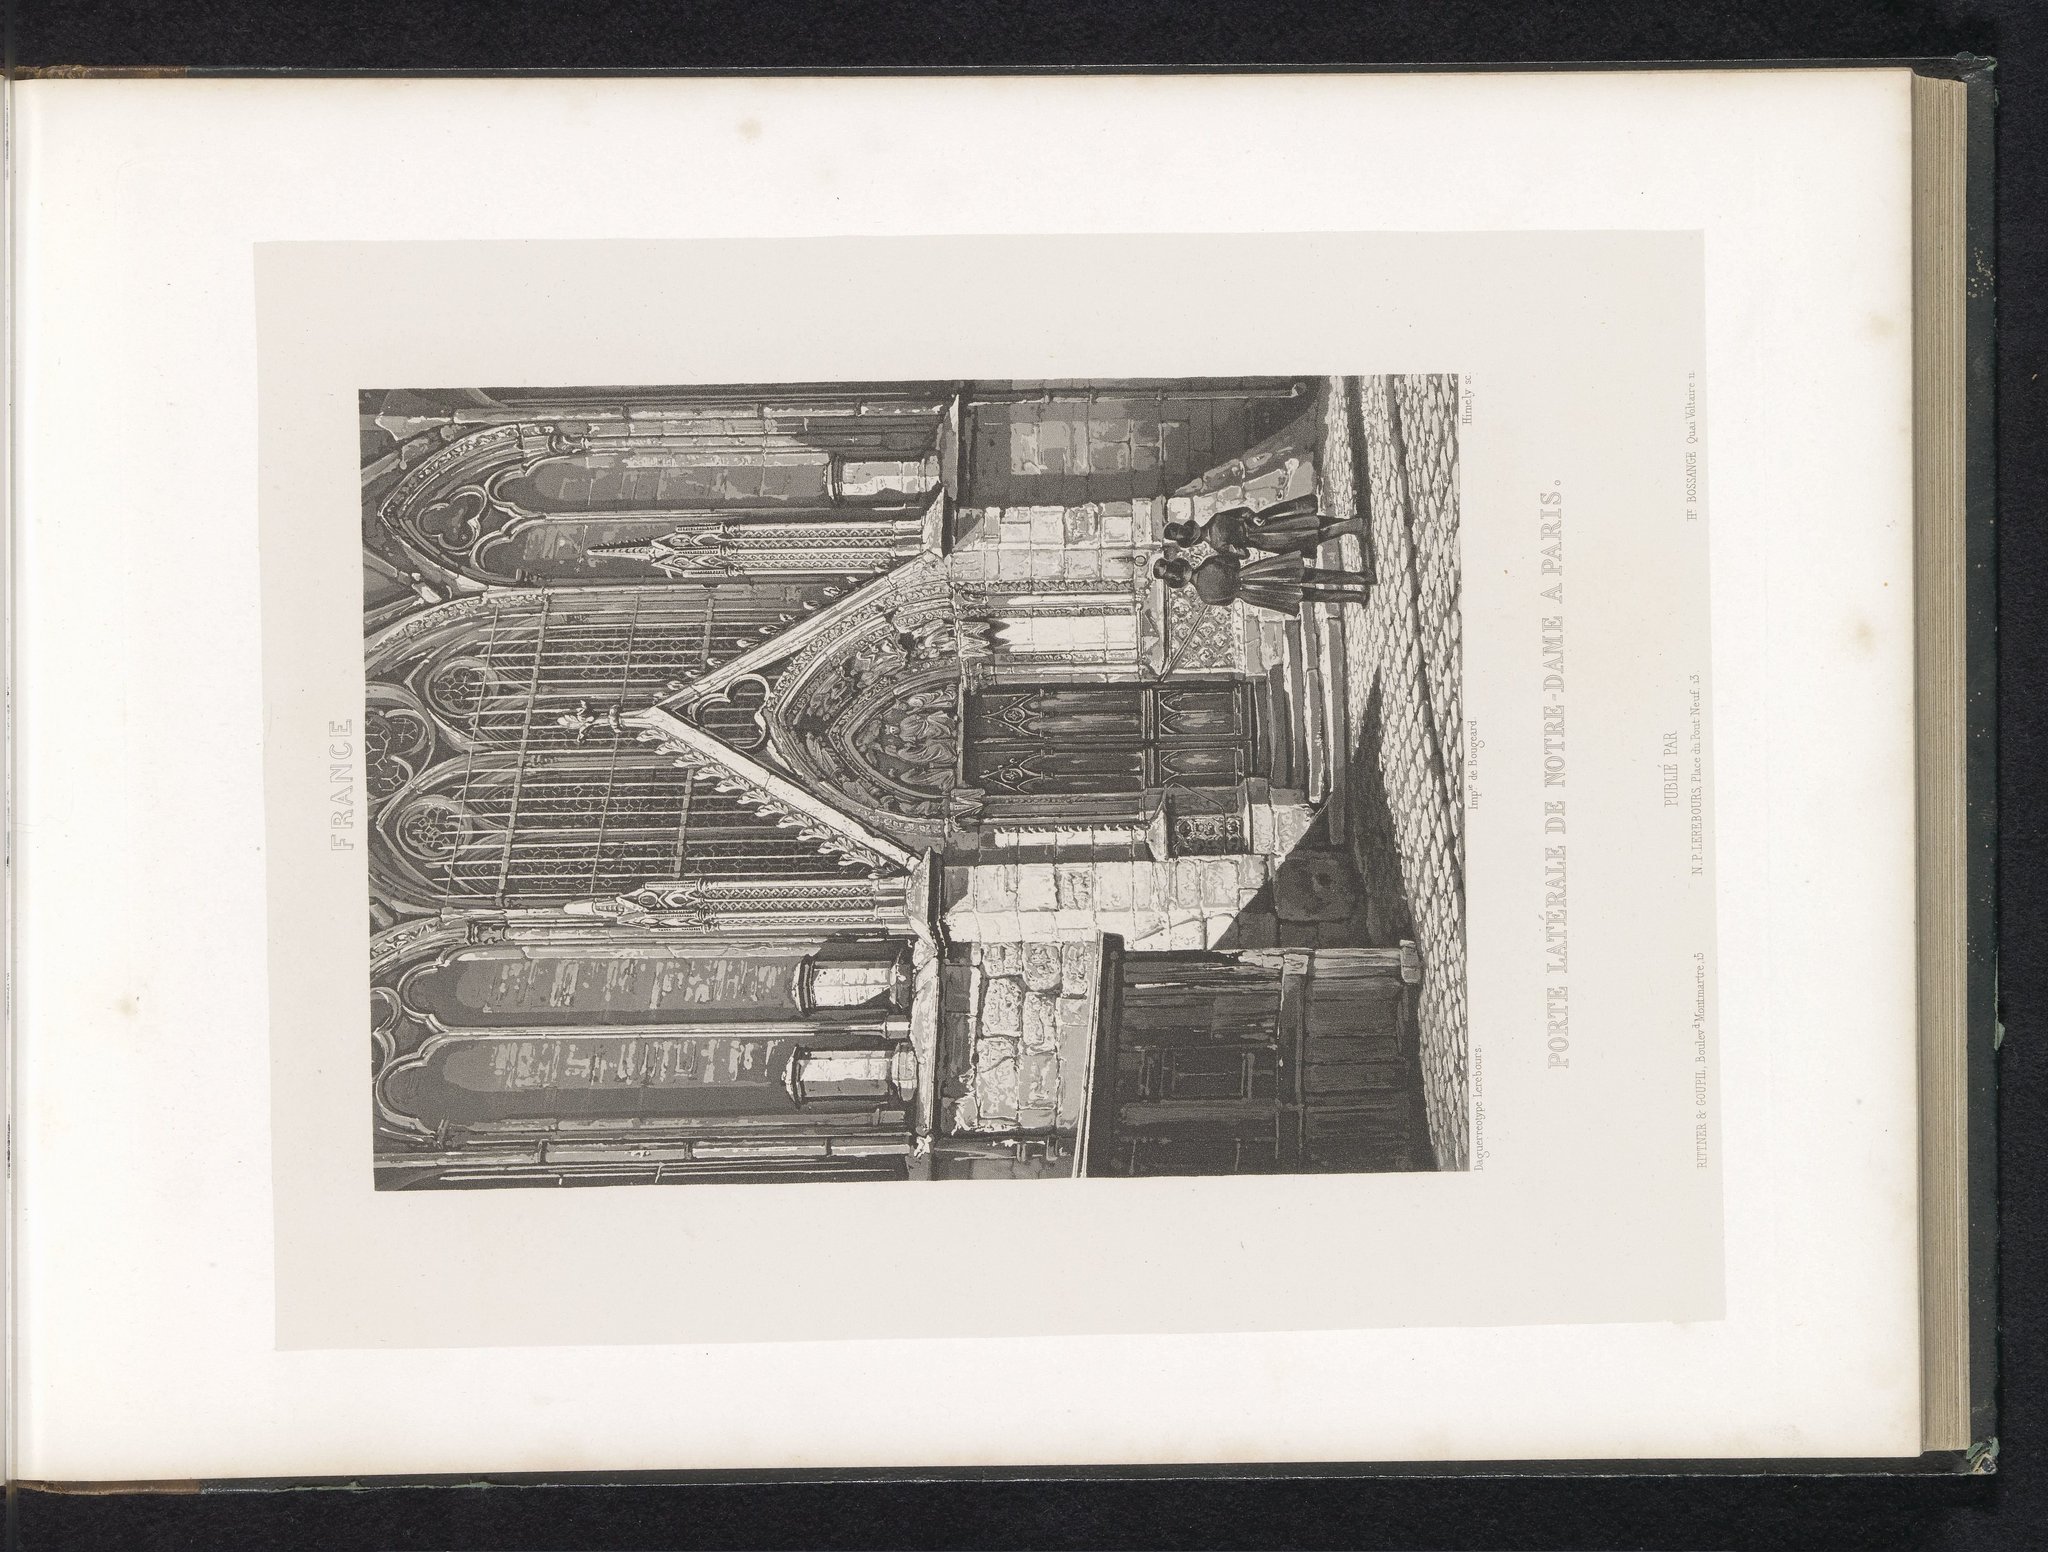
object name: page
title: Porte latérale de Notre-Dame a Paris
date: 1839-1841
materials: paper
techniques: aquatint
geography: paris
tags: parts of church exterior and annexes: portal, façade (of house or building)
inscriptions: inscription: ‘Rittner & Goupil Boulevd Montmartre 15’, inscription: ‘Hr. Bossance Quai Voltaire 11’, inscription: ‘N.P. Lerebours Place du Pont Neuf 15’